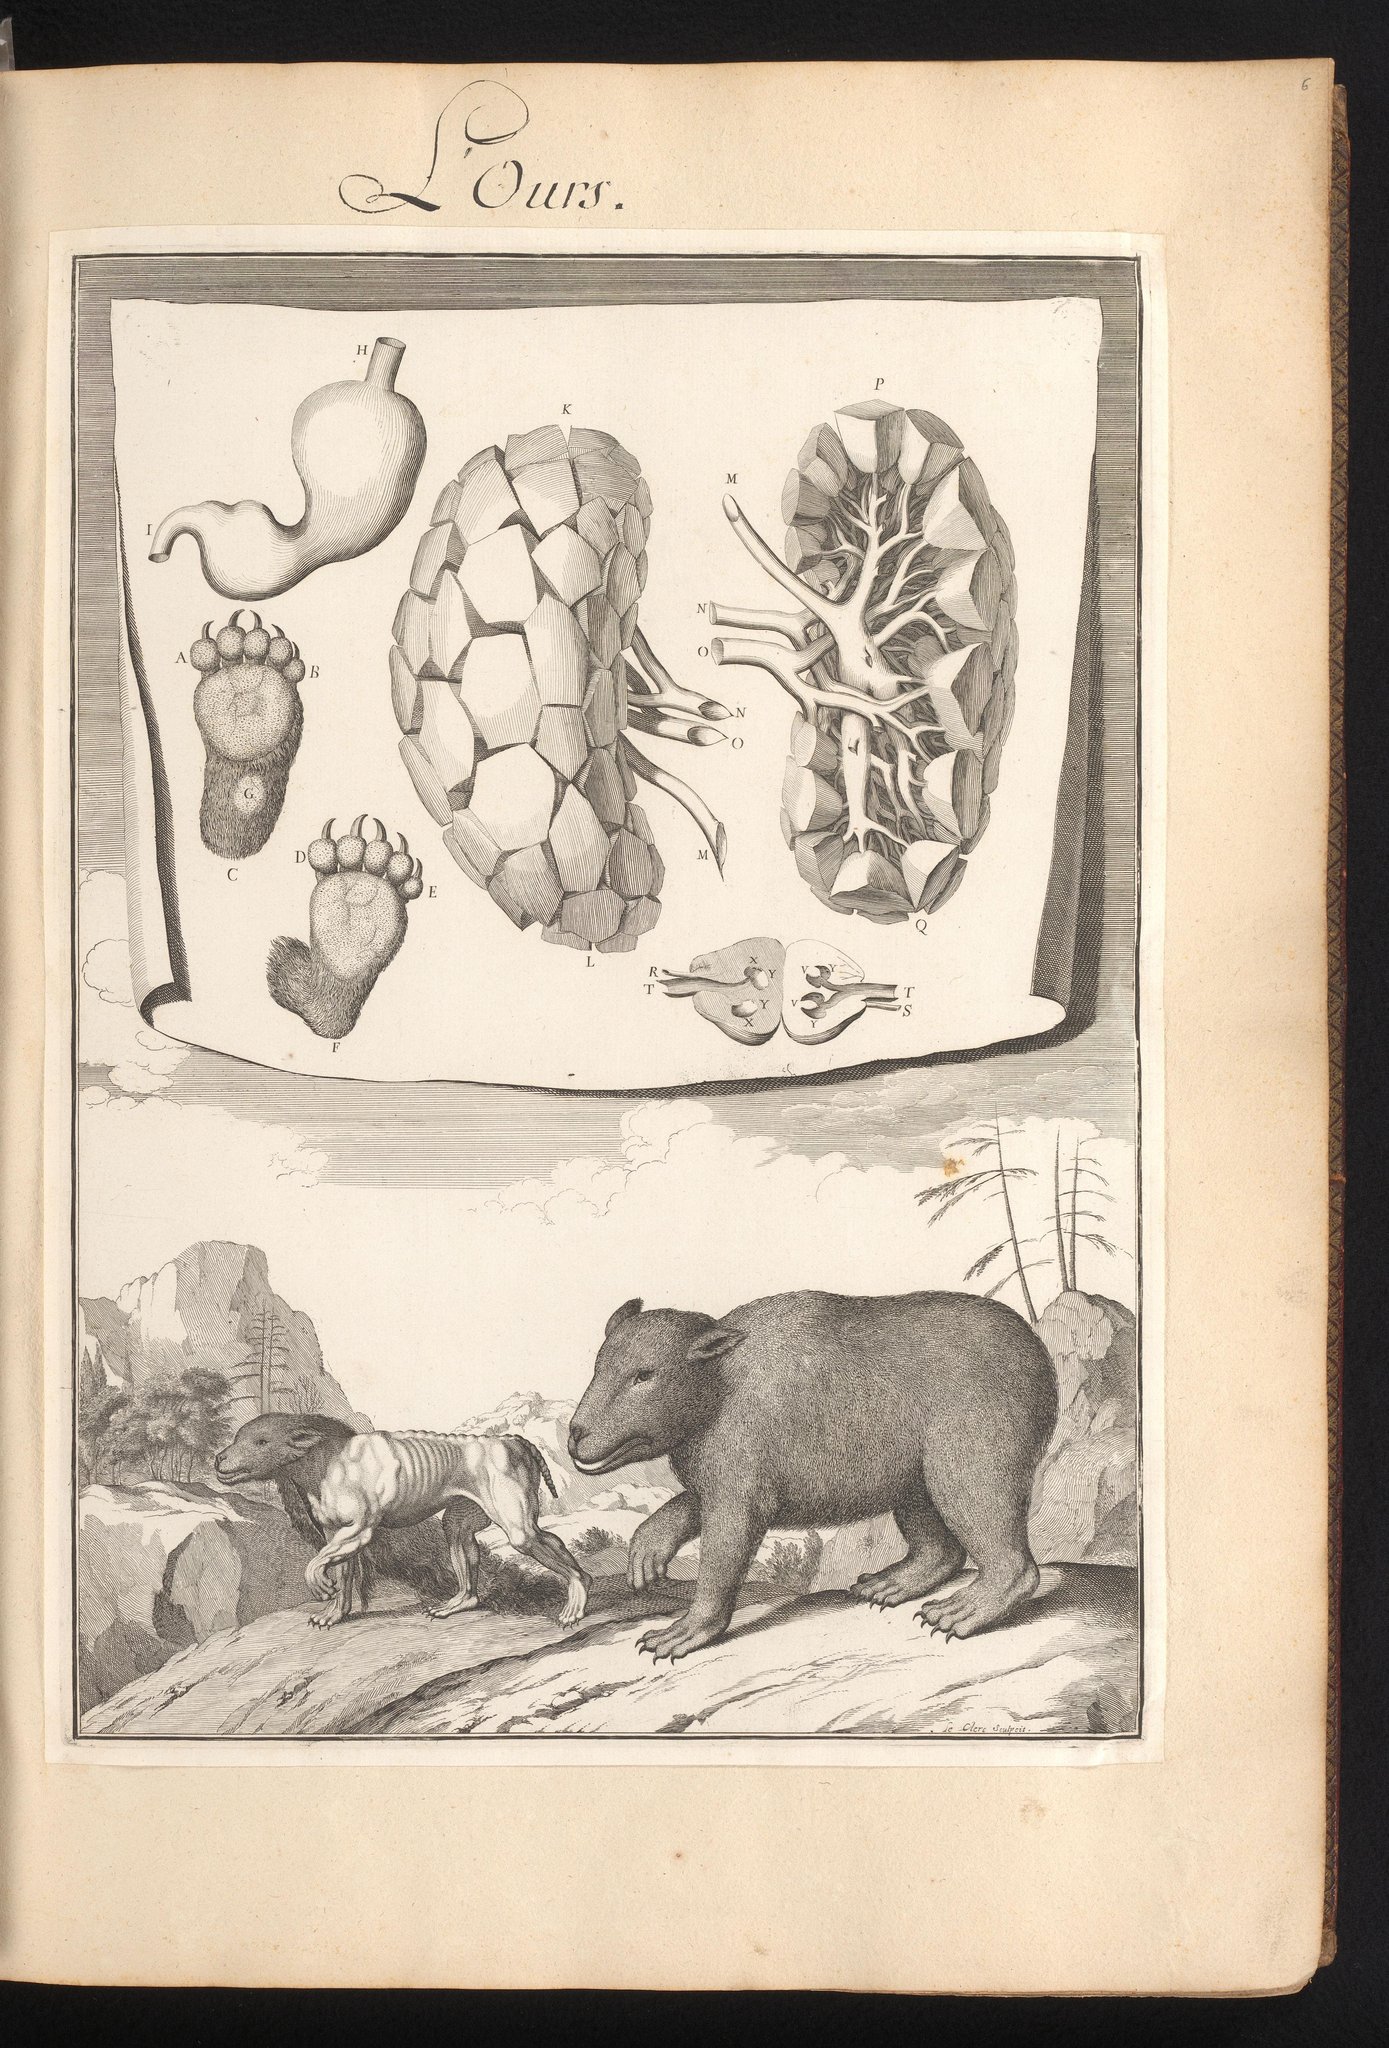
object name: book illustration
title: Twee beren, waarvan één gevild, in een landschap met bovenaan op een blad de organen en botten van het dier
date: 1669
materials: ink, paper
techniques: engraving, etching, pen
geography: paris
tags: dissection, beasts of prey, predatory animals: bear (+ anatomy of animals), beasts of prey, predatory animals: bear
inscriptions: inscription: ‘L'Ours.’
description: Prent uit: Perrault, Claude. Description anatomique d'un cameleon, d'un castor, d'un dromadaire, d'un ours et d'une gazelle. Parijs: Frédéric Léonard, 1669.